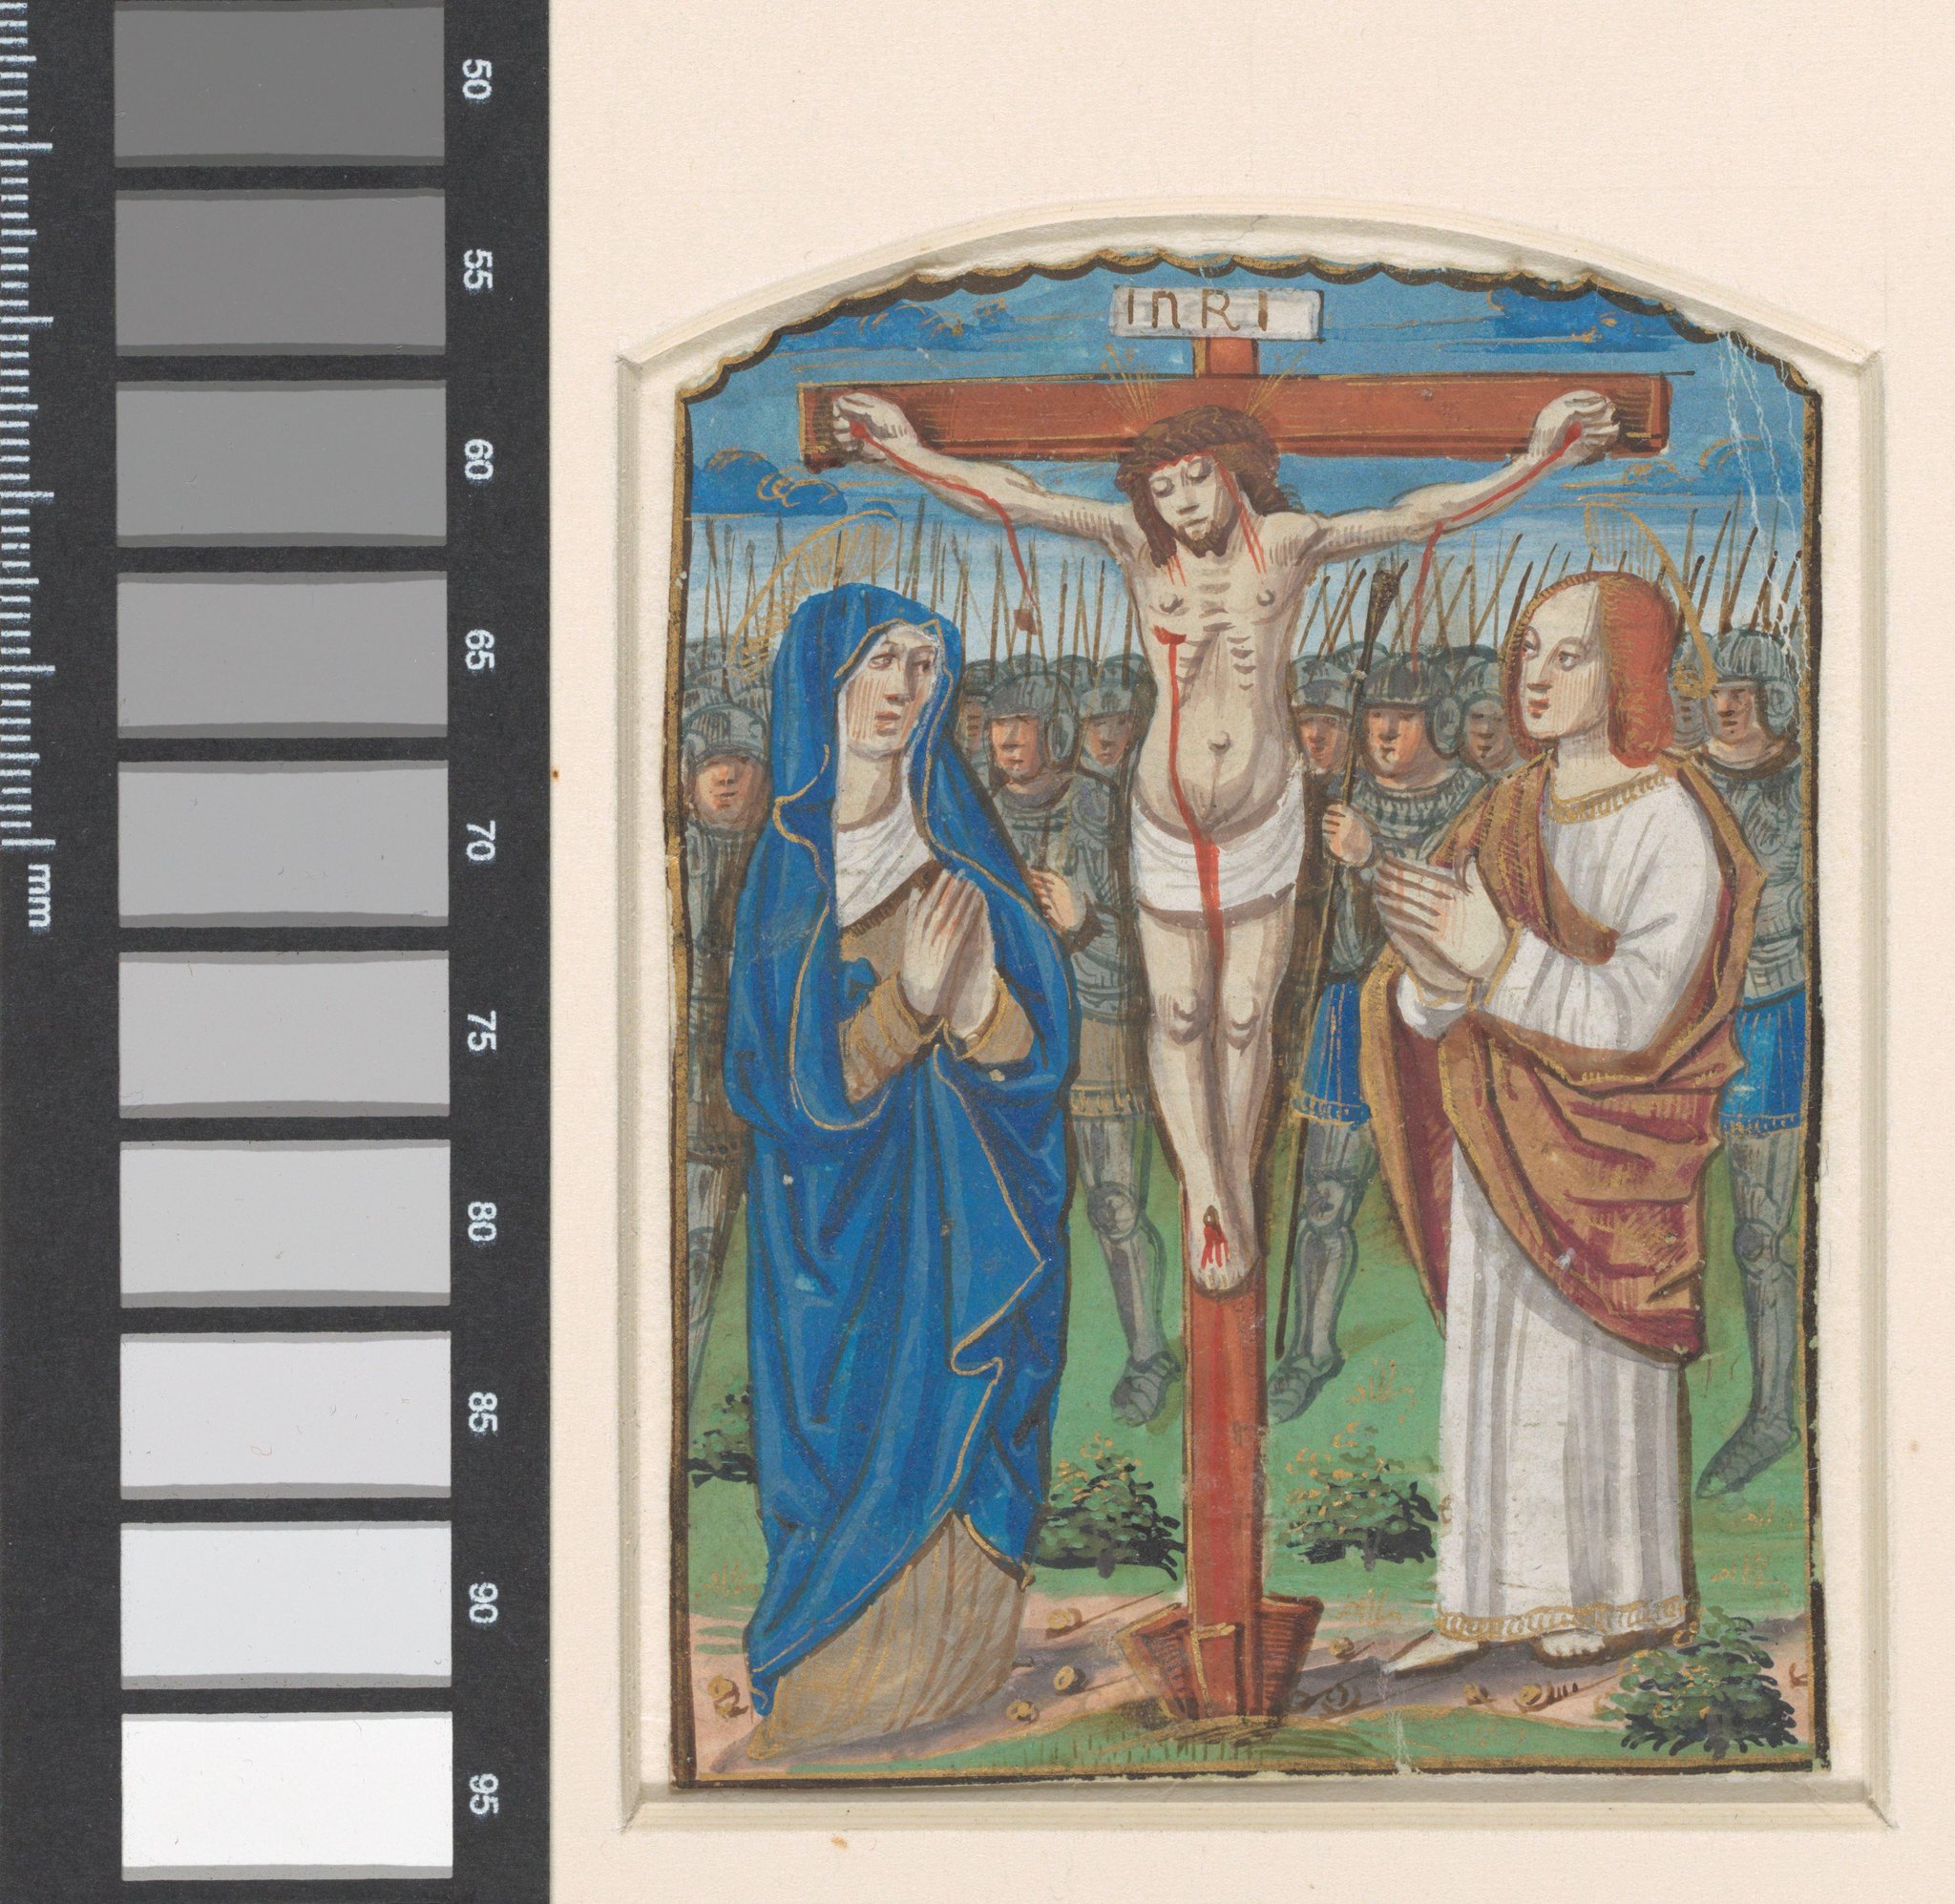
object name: drawing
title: Miniatuur uit een getijdenboek: Christus aan het kruis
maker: Anonymous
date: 1475-1500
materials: paint, gold leaf, parchment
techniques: brush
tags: crucified christ with mary and john on either side of the cross; holy rood